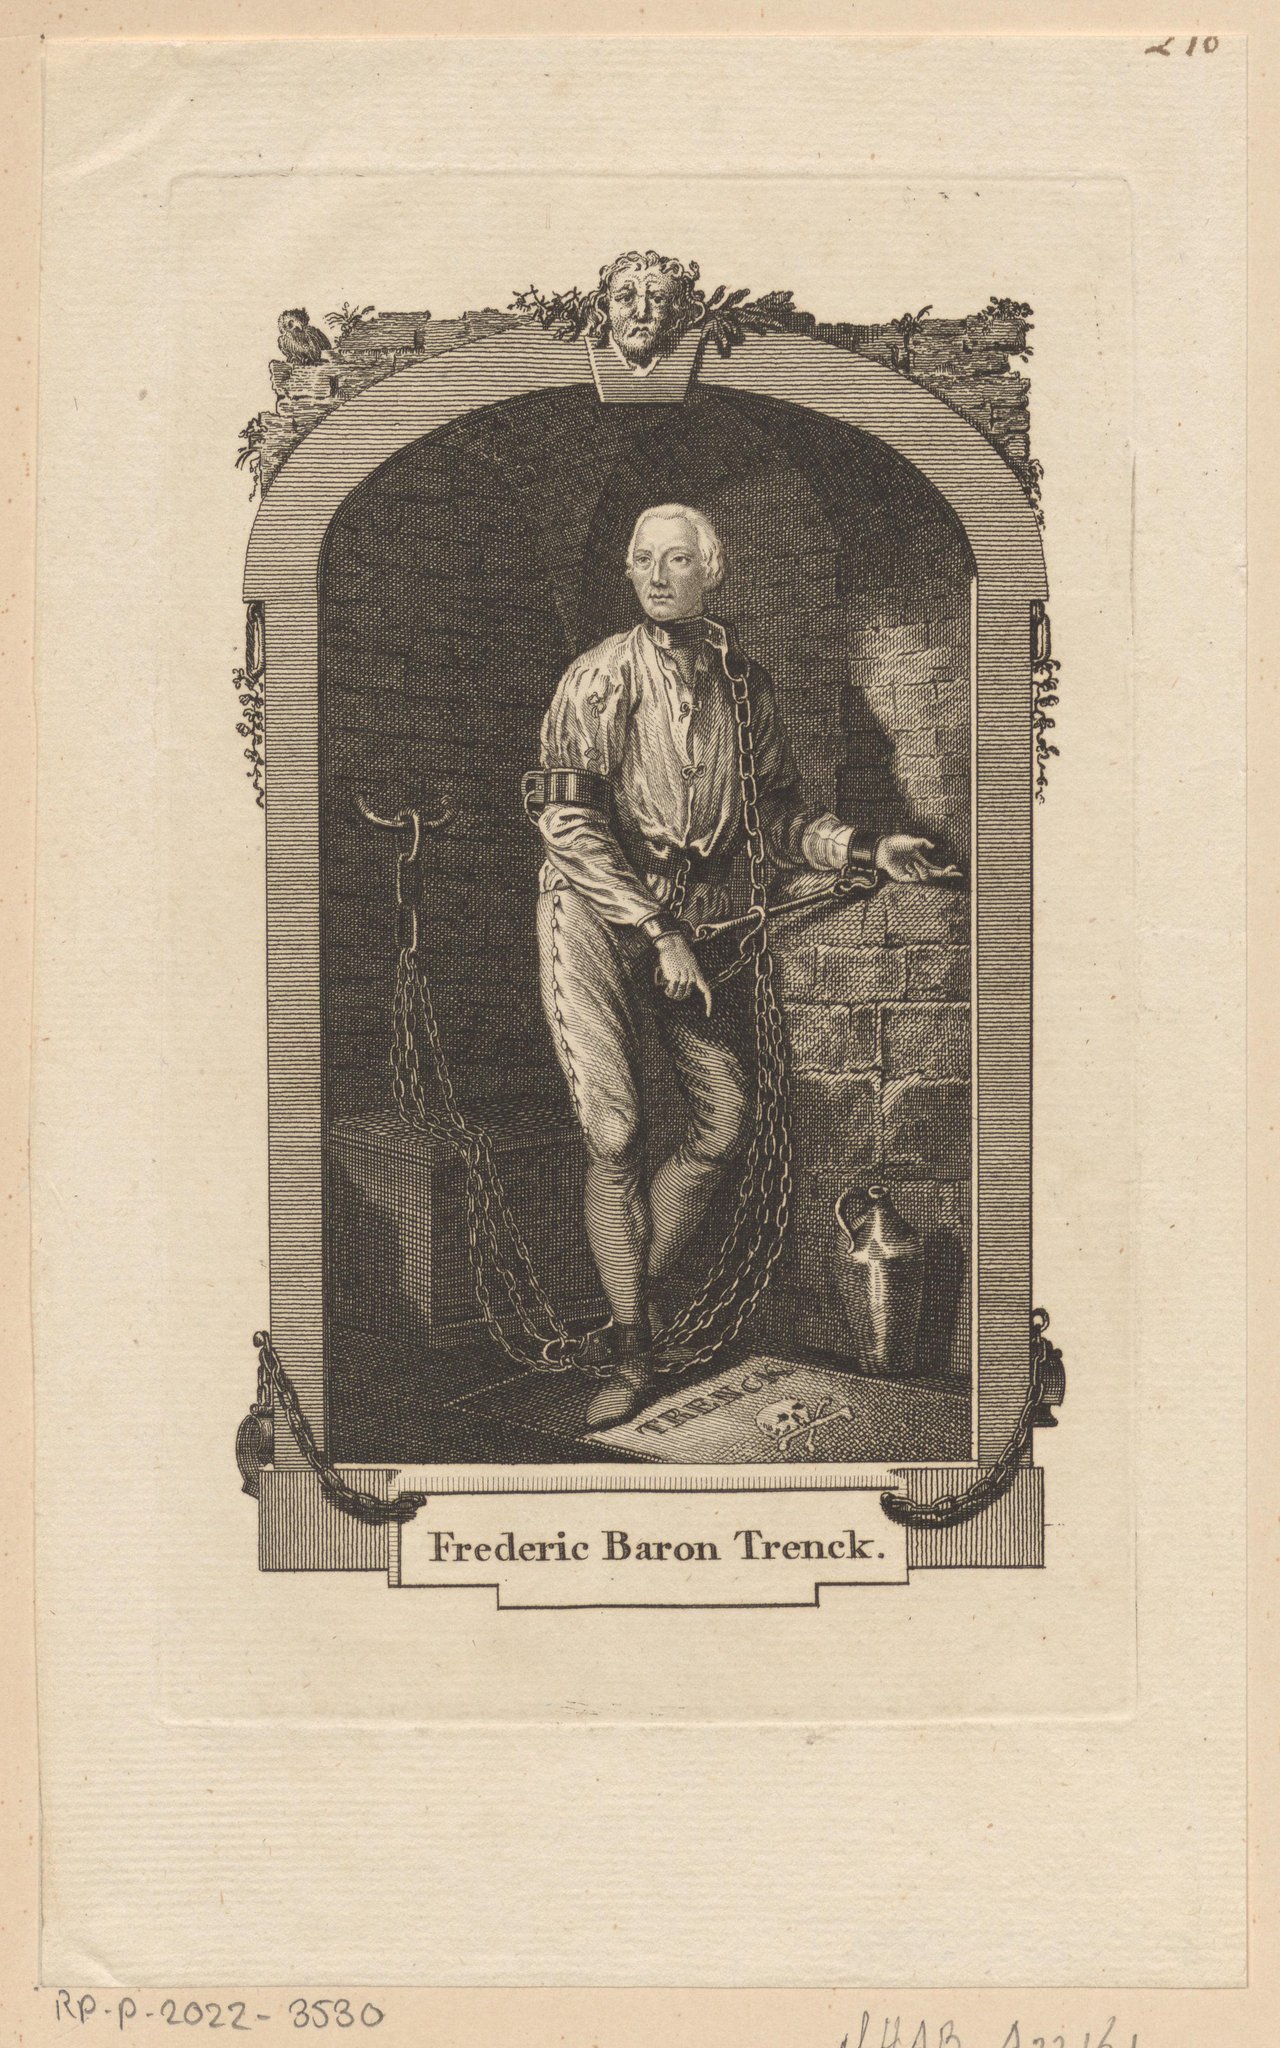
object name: print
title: Portret van Friedrich von der Trenck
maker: Anonymous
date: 1787-1793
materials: paper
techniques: engraving, etching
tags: prison, jail, historical persons, portrait of a writer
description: Prent waarschijnlijk uit een editie van: Trenck, Friedrich von der. Merkwürdige Lebensgeschichte (...). S.l.s.n., 1787-1793.